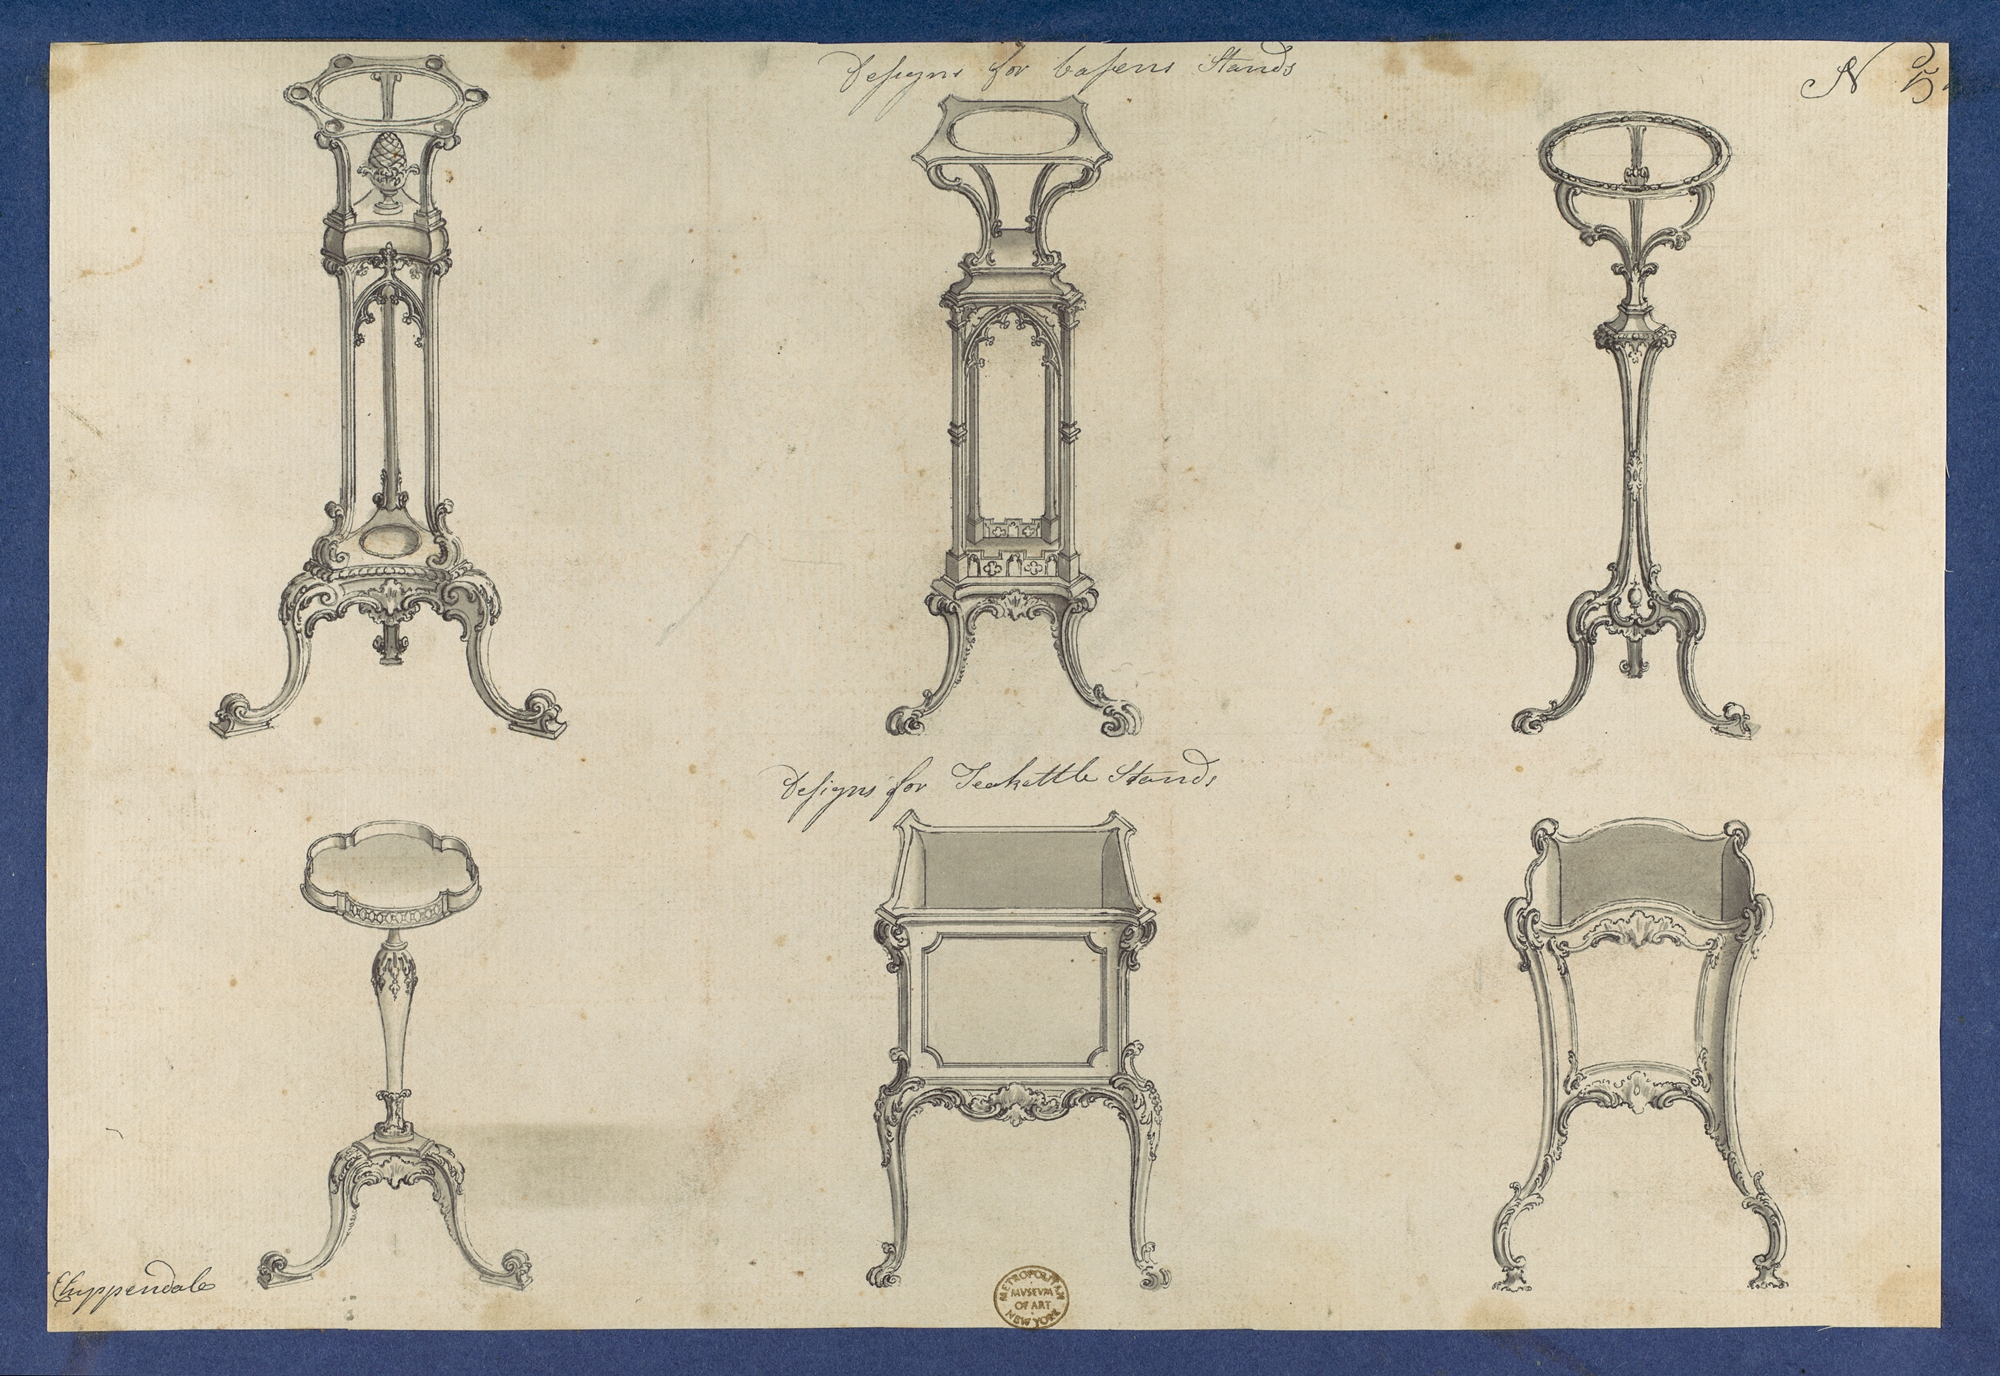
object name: drawing ornament architecture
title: Designs for Basin Stands and Teakettle Stands, in Chippendale Drawings, Vol. I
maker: thomas chippendale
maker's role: artist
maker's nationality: british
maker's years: 1718-1779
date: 1761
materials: ink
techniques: wash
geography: london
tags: furniture